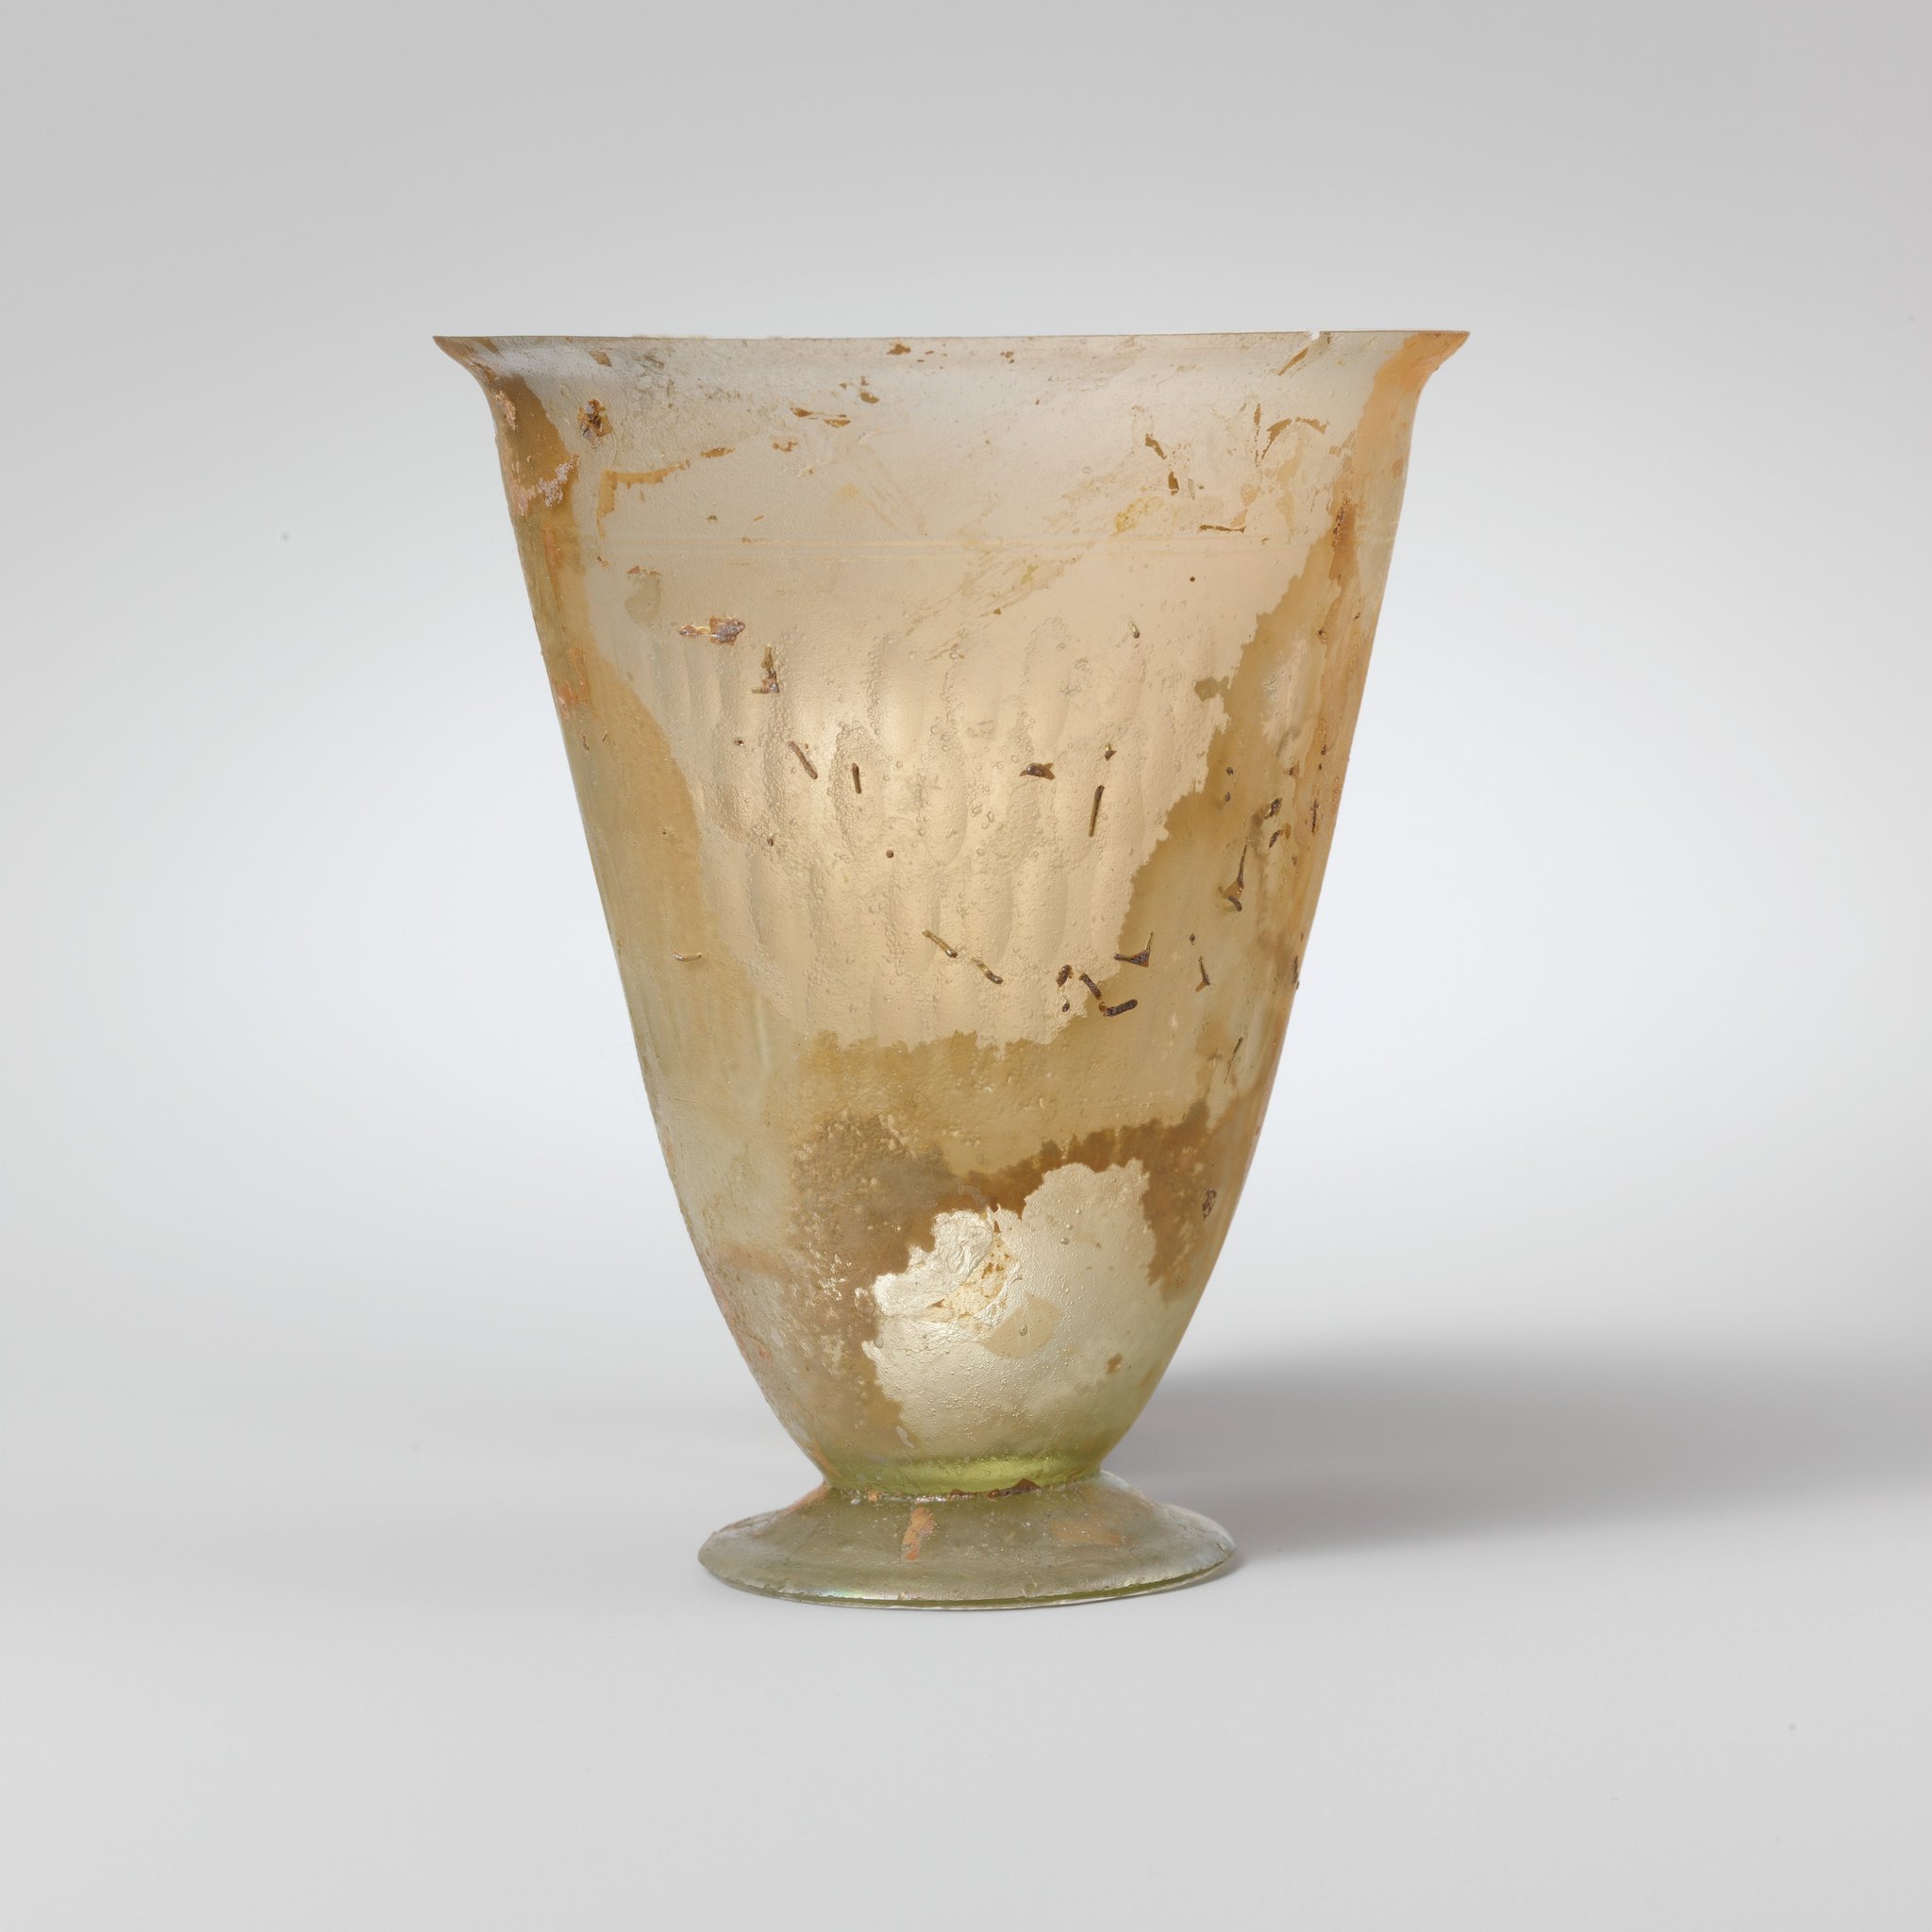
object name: beaker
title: Glass beaker with facet-cut decoration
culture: roman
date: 101-200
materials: glass